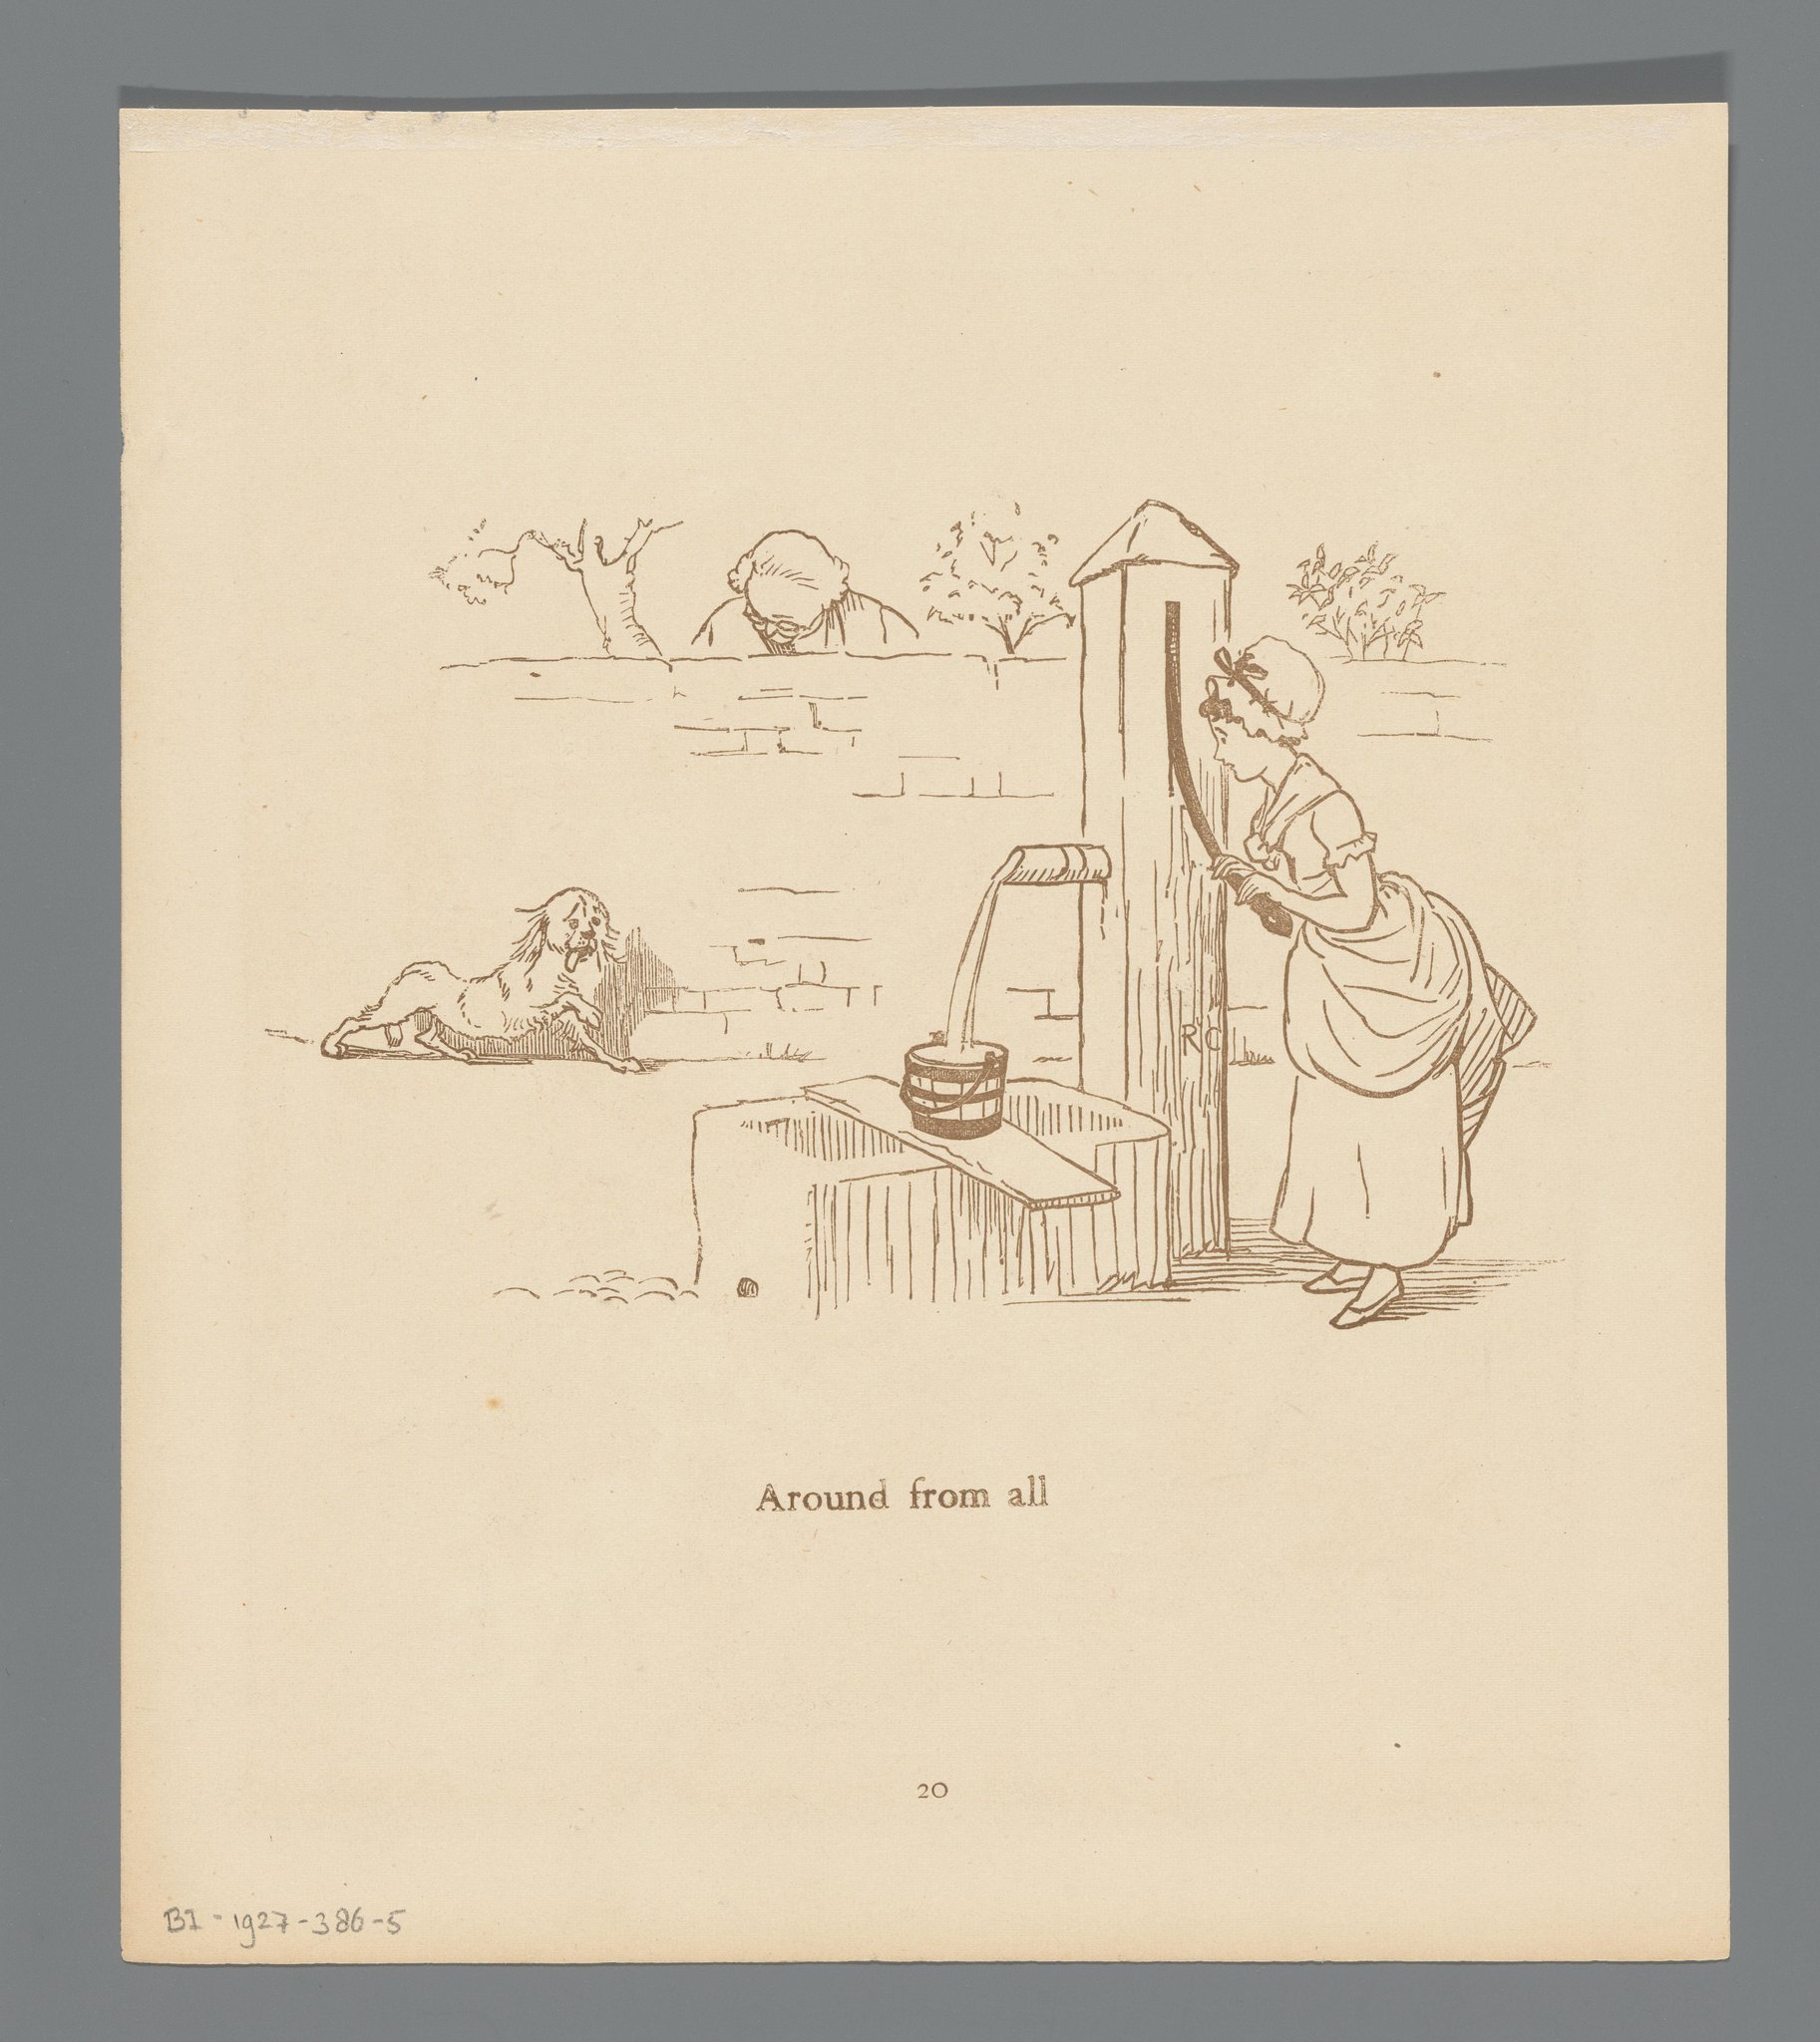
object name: book illustration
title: Vrouw bij een waterpomp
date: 1879-1927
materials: paper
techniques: letterpress printing, engraving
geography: london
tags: adult woman, utilitarian, public pump or water fountain, dog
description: Prent uit: Goldsmith, Oliver. Elegy on a mad dog. Londen: George Routledge & Sons, 1879. Of uit een later gepubliceerde uitgave waarin vier verhalen (waaronder 'Elegy on a mad dog') zijn gebundeld.